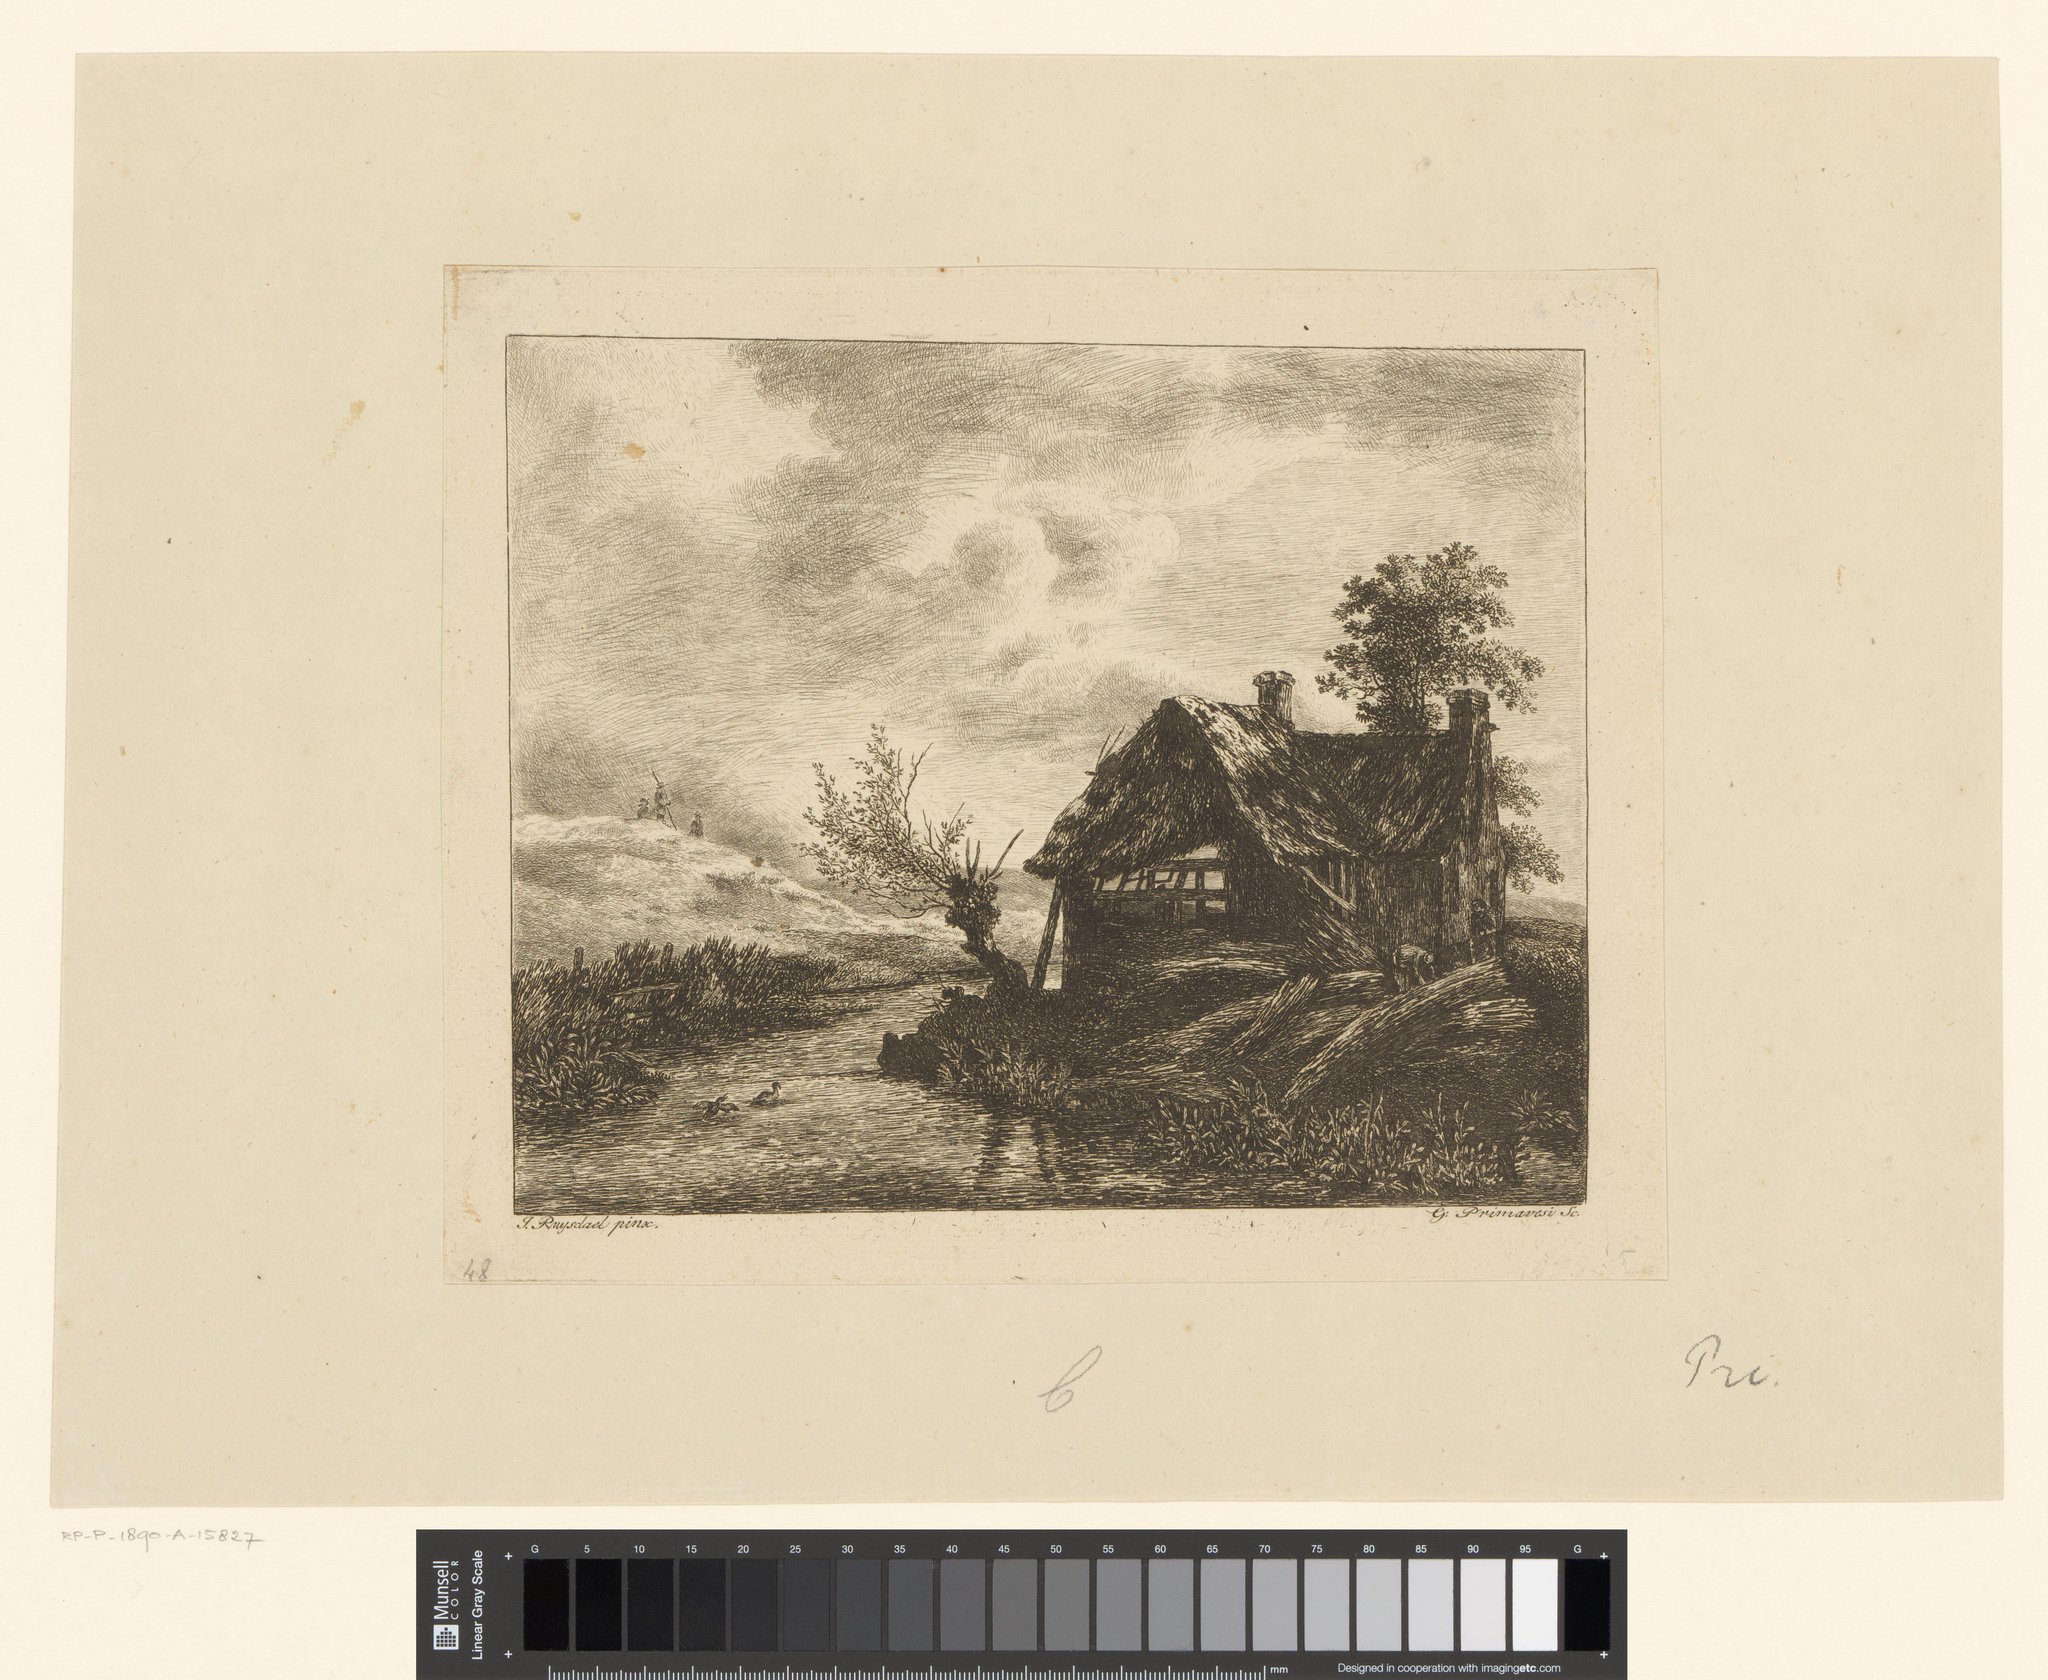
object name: print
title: Landschap met een hut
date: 1789-1855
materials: paper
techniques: etching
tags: landscapes with waters, waterscapes, seascapes (in the temperate zone), hut, cabin, lodge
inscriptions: collector's mark: Lugt 2228